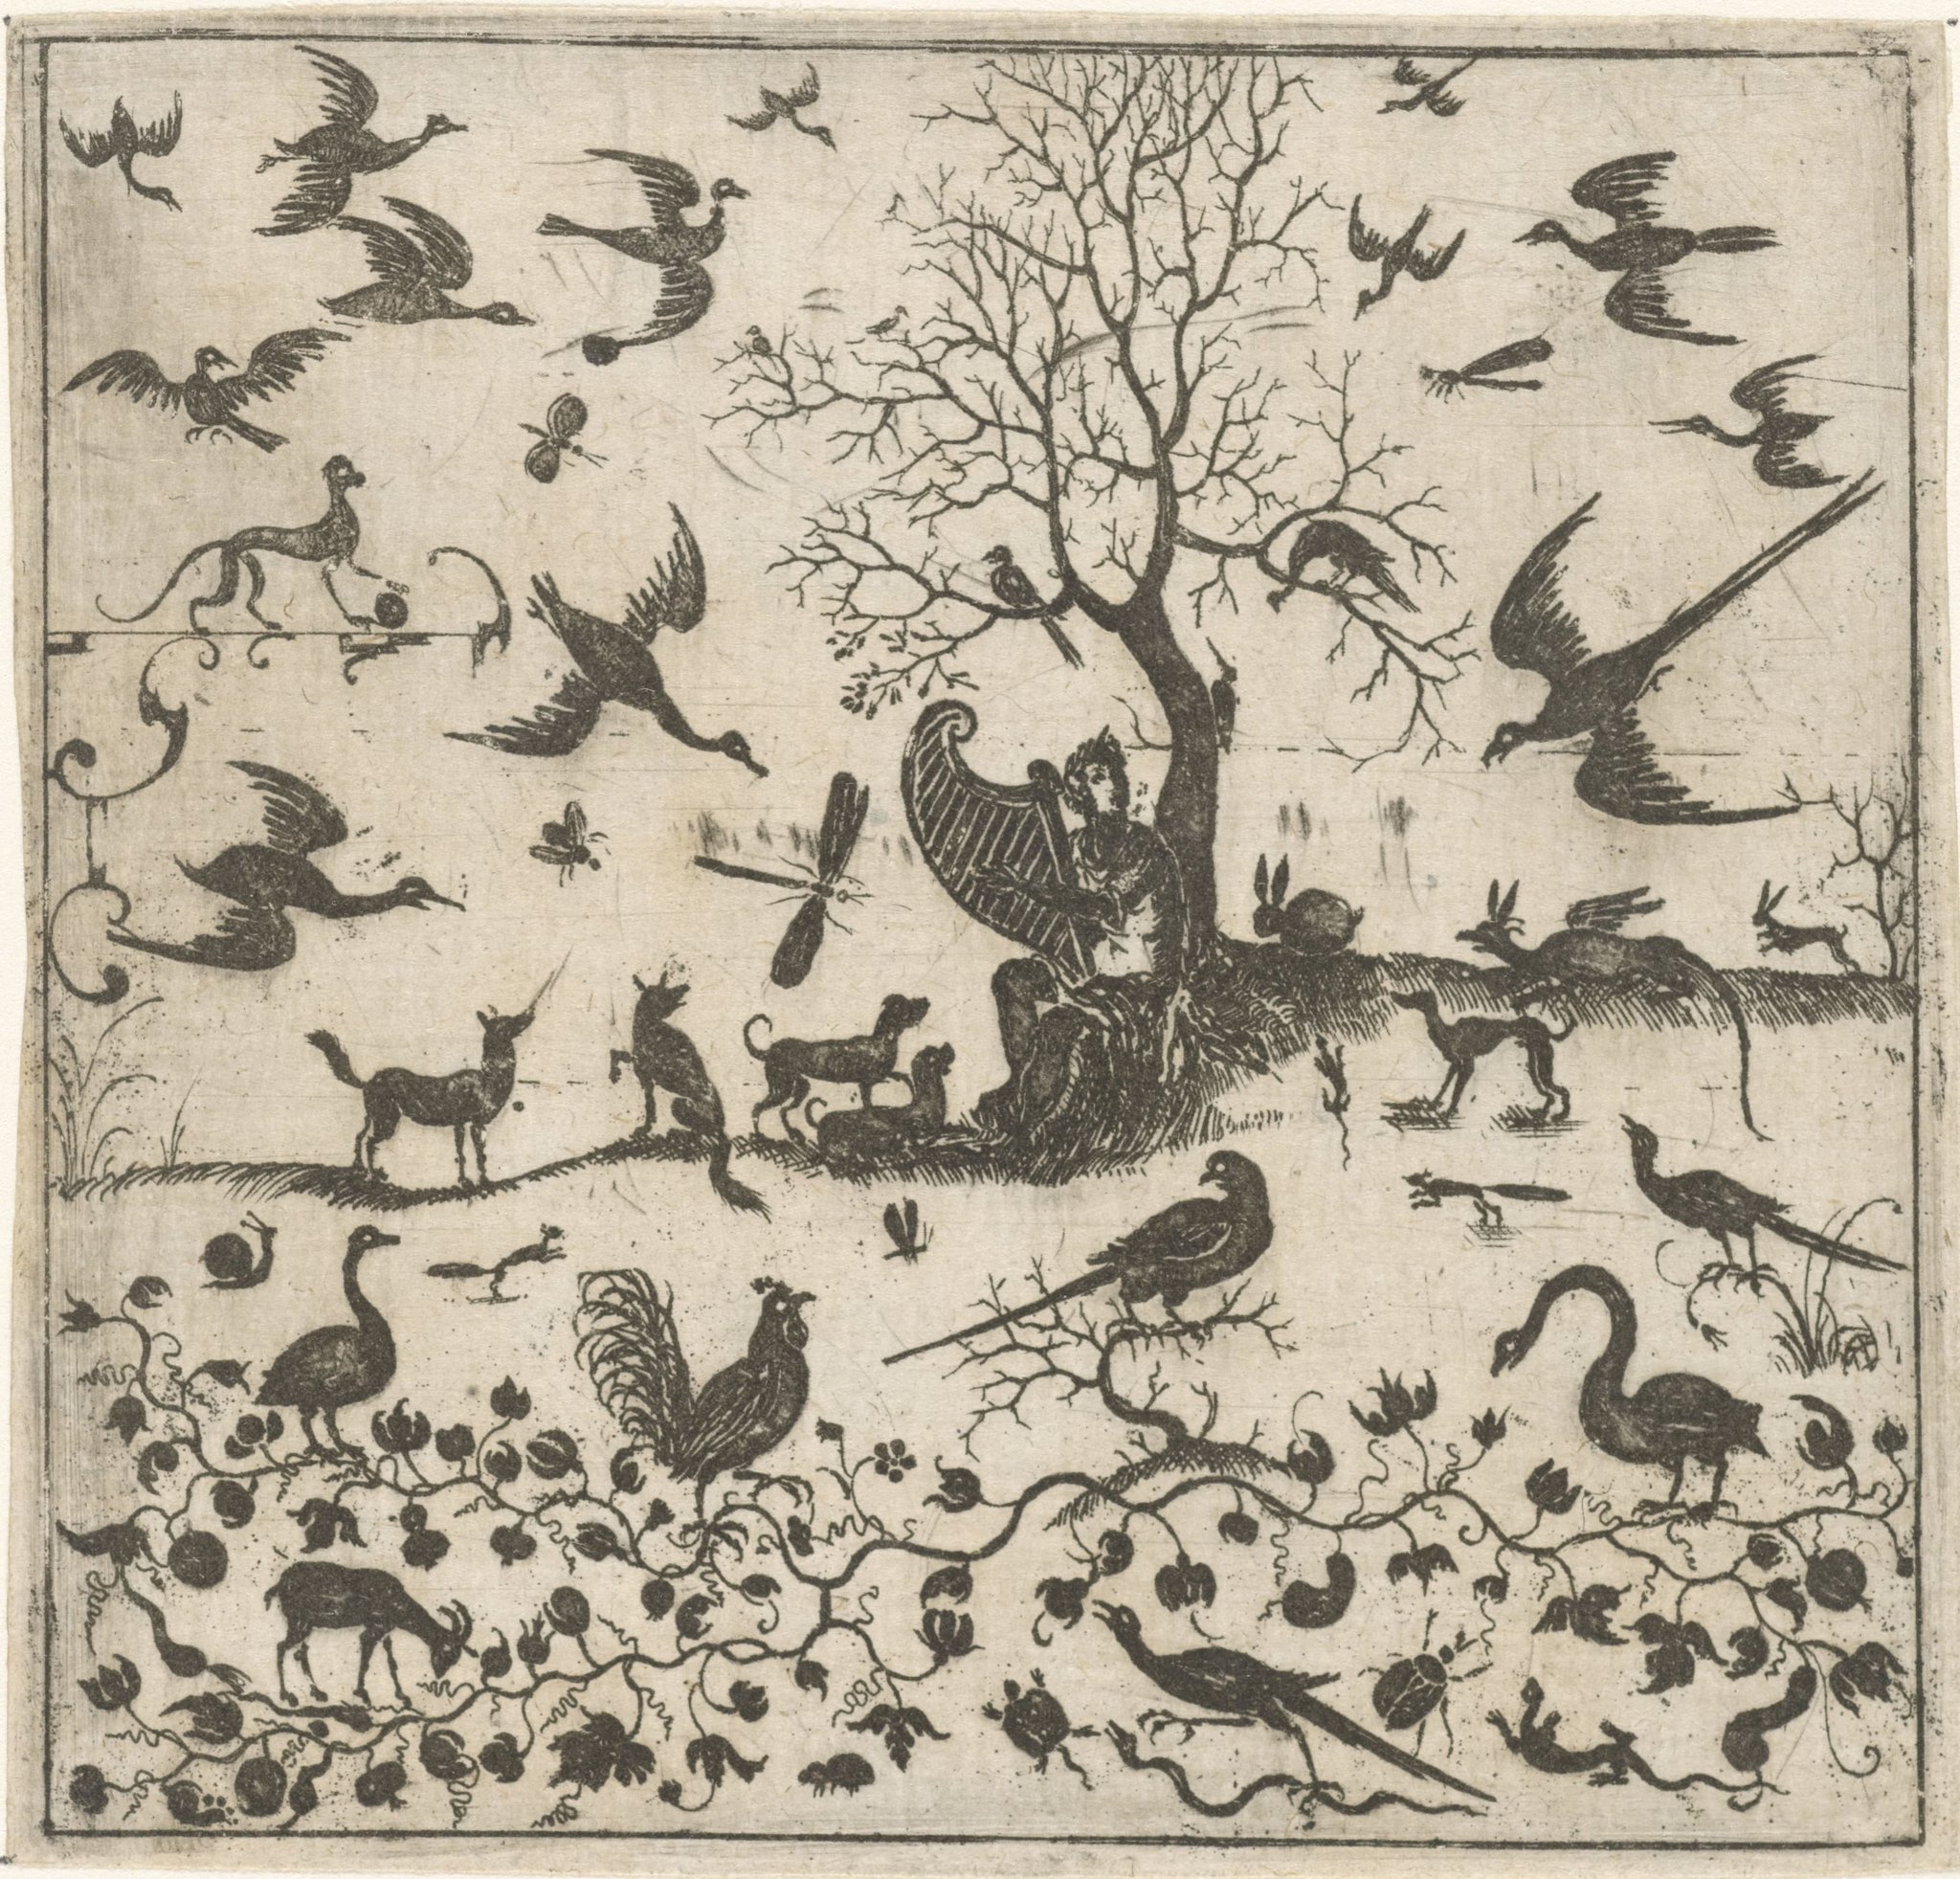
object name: ornament print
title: Schweifwerk ornamenten voor edelsmeden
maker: esaias van hulsen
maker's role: engineer, goldsmith, print maker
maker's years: 1570-1626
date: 1617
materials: paper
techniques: etching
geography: stuttgart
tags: orpheus playing the lyre: trees and rocks move, beasts and birds are enchanted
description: Orpheus zit met zijn lier tegen een boom. Met zijn muziek betovert hij de vogels en andere dieren om hem heen. Onderaan een wingerd met daartussen verschillende vogels en dieren.